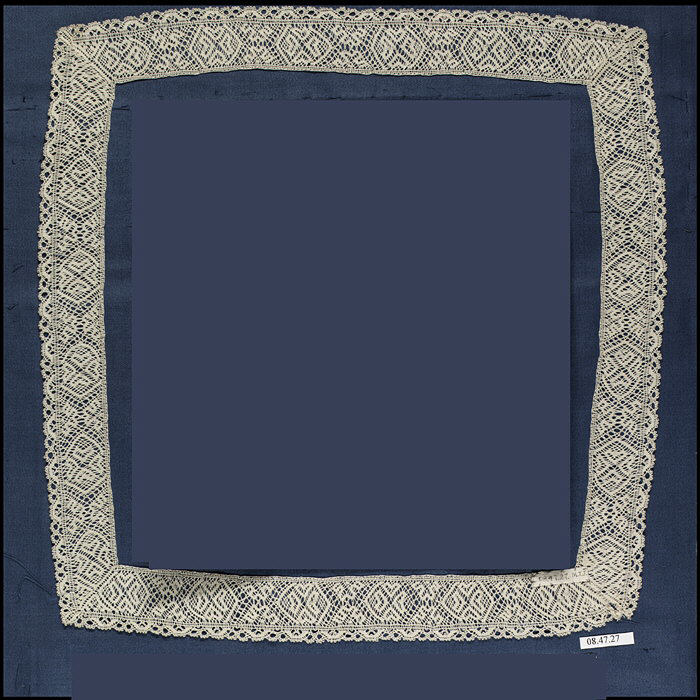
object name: handkerchief border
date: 1801-1900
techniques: lace